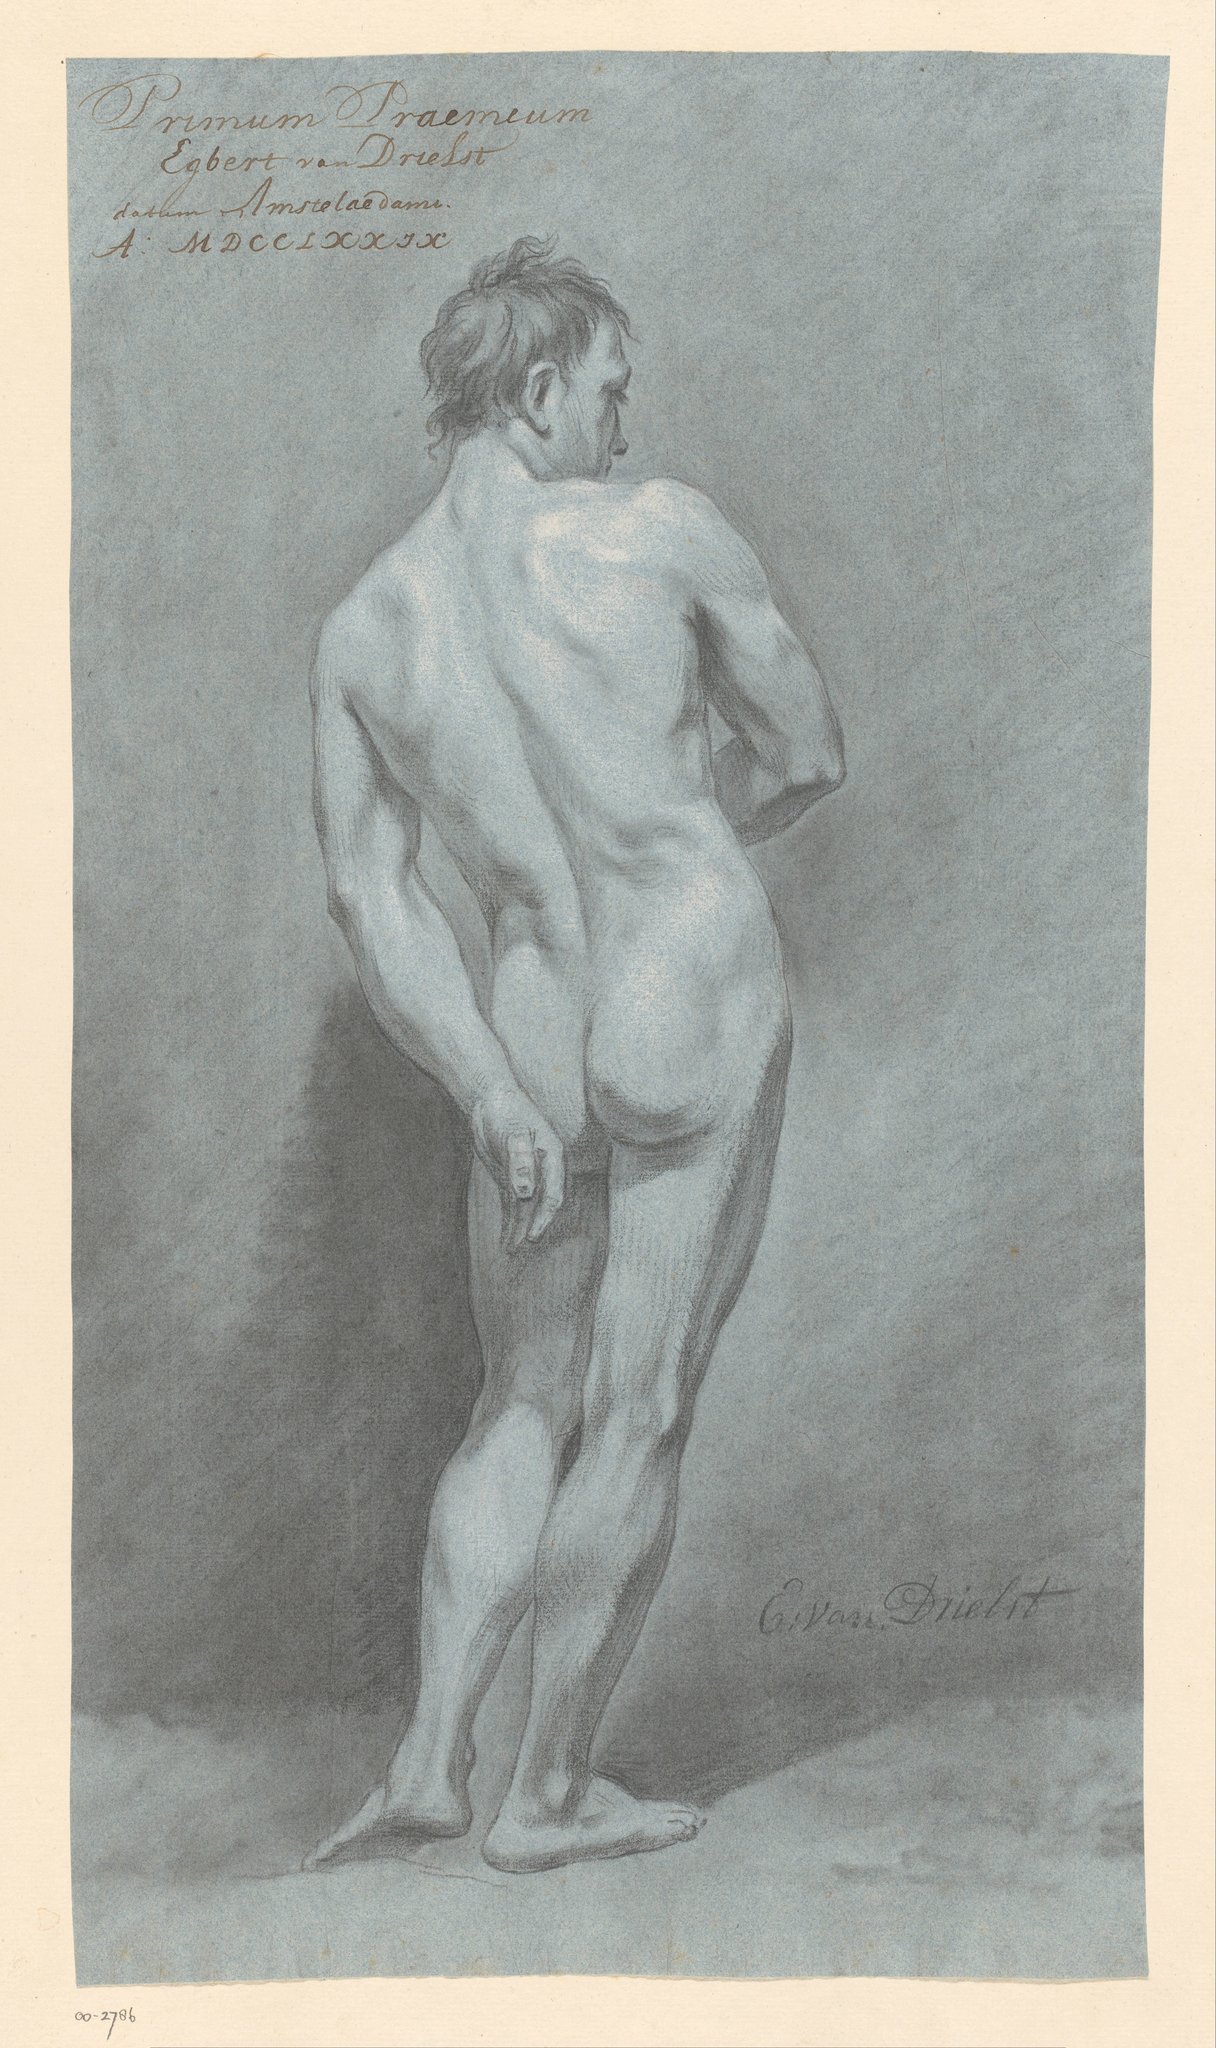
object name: drawing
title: Staand mannelijk naakt, op de rug gezien (1e prijs 1779)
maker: egbert van drielst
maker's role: draughtsman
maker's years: 1745-1818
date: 1779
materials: chalk, paper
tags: standing figure (+ nude human being)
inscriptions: date: ‘10 Feb.’